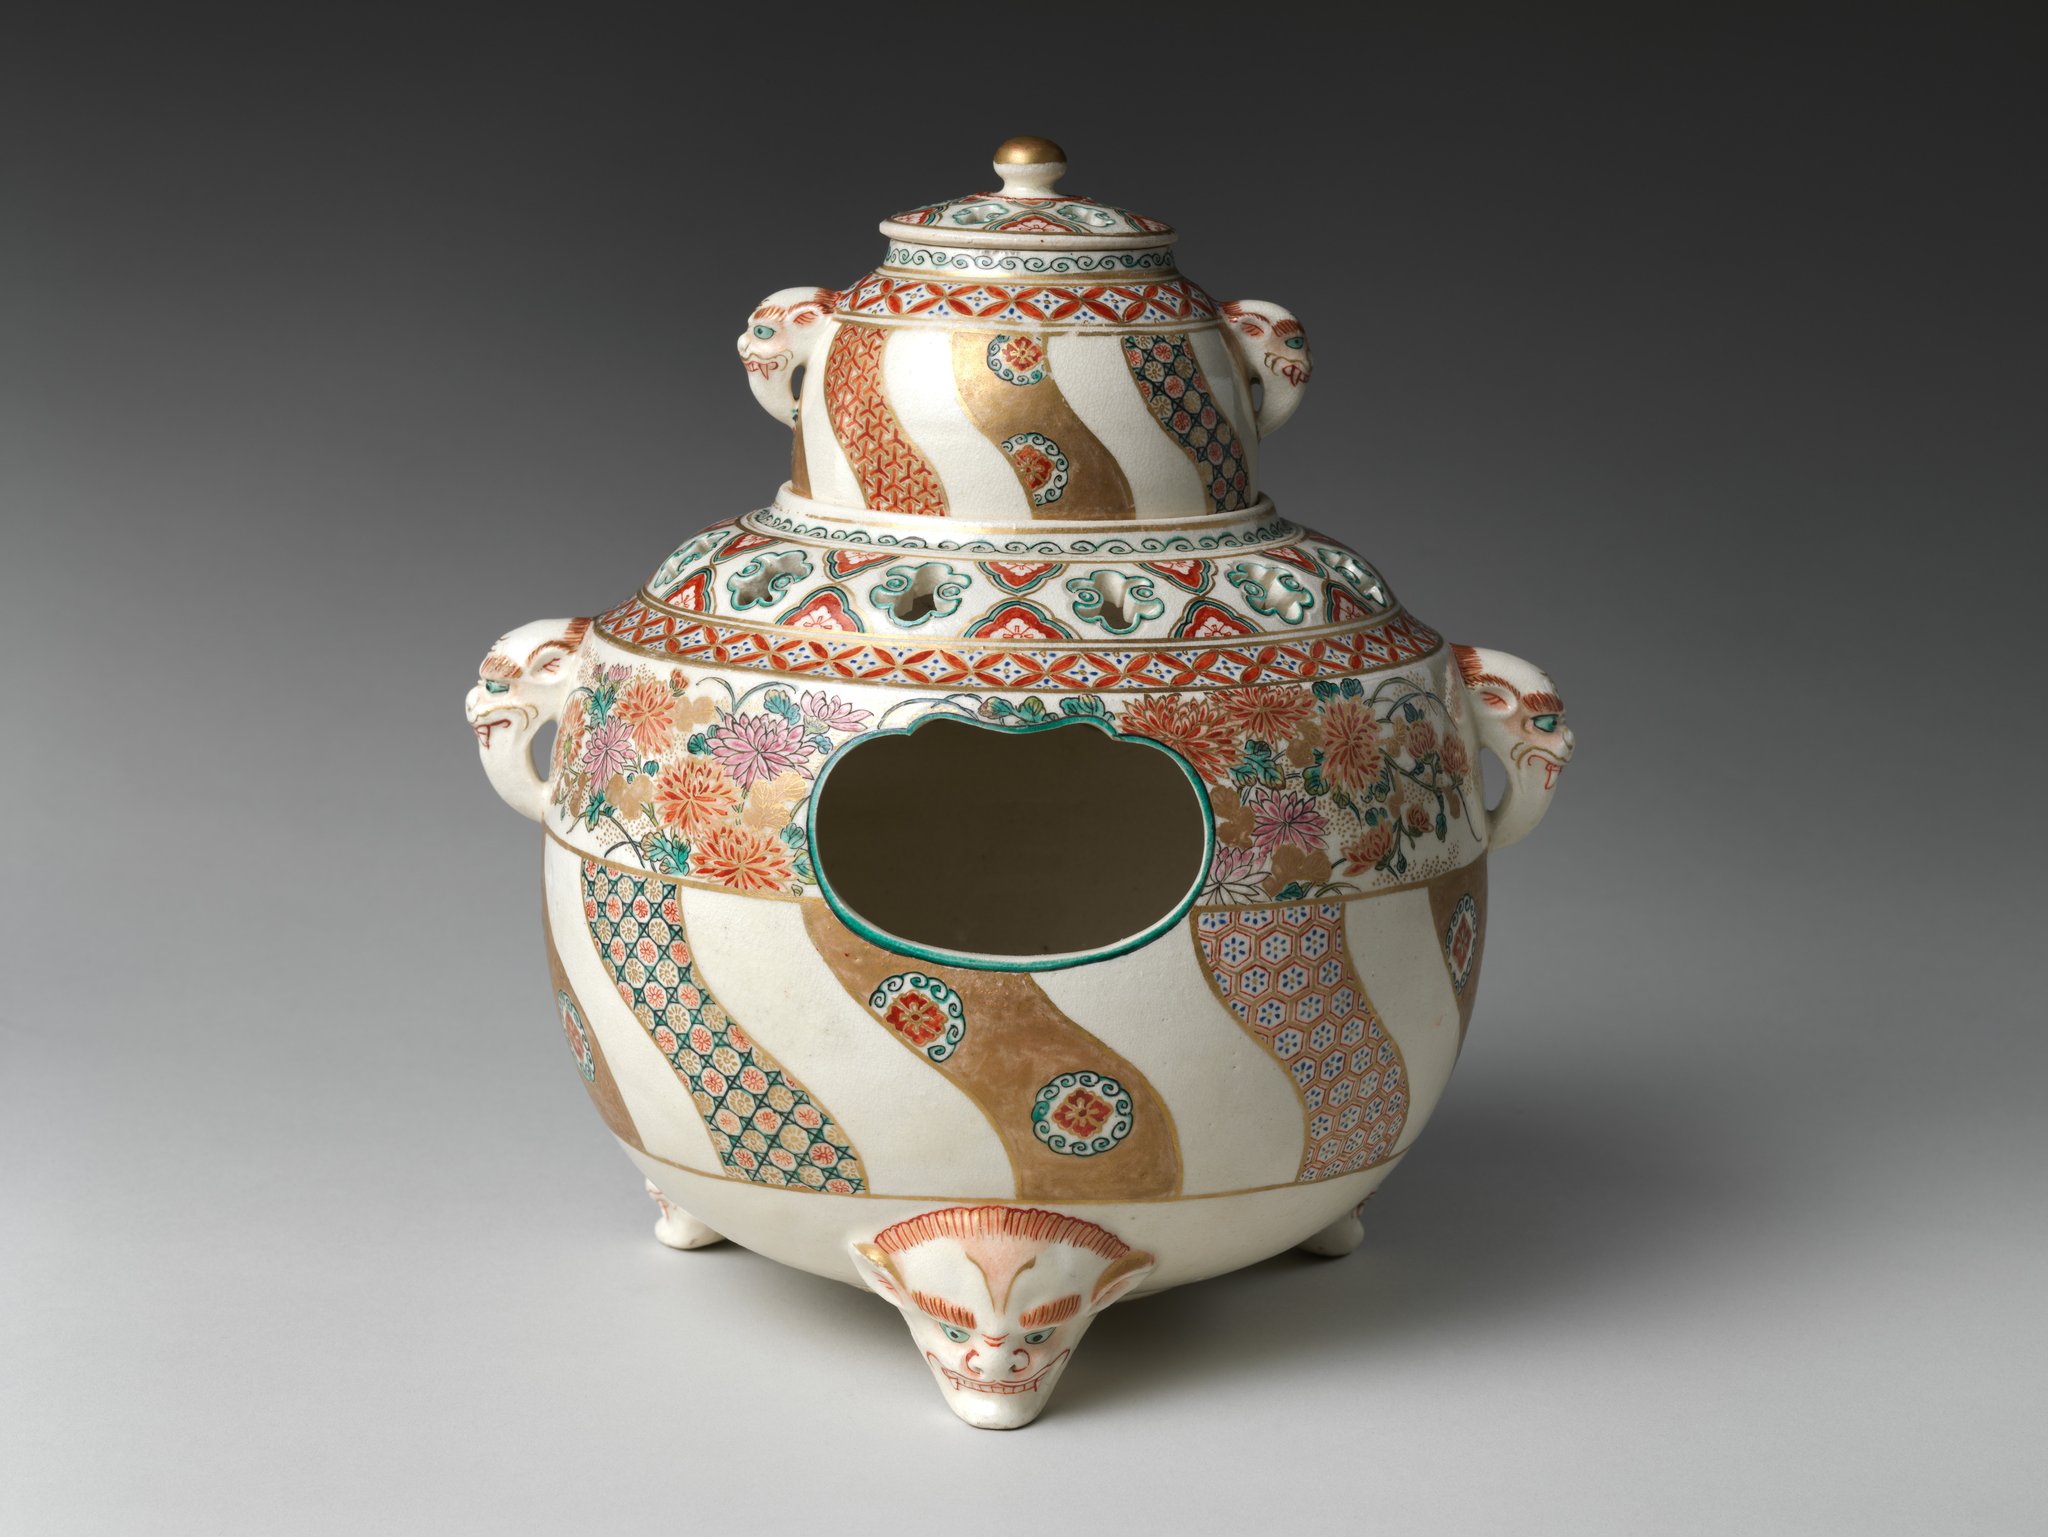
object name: clove boiler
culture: japanese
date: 1834-1866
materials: enamel, glaze, gold, stoneware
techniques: polychrome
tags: flowers